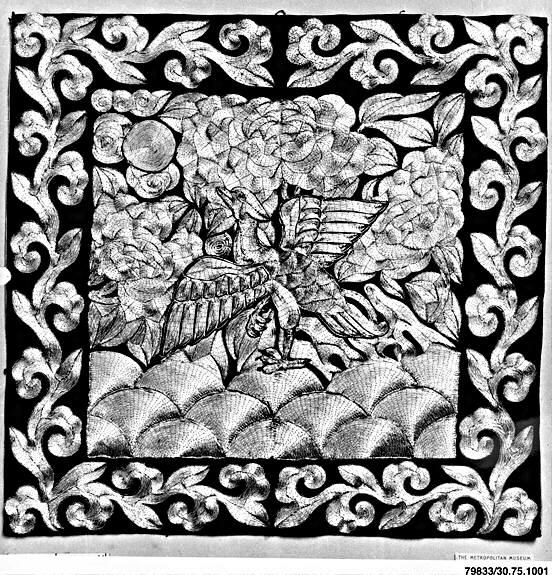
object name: rank badge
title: Rank Badge with Mandarin Duck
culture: chinese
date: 1801-1900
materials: metal thread, silk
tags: ducks